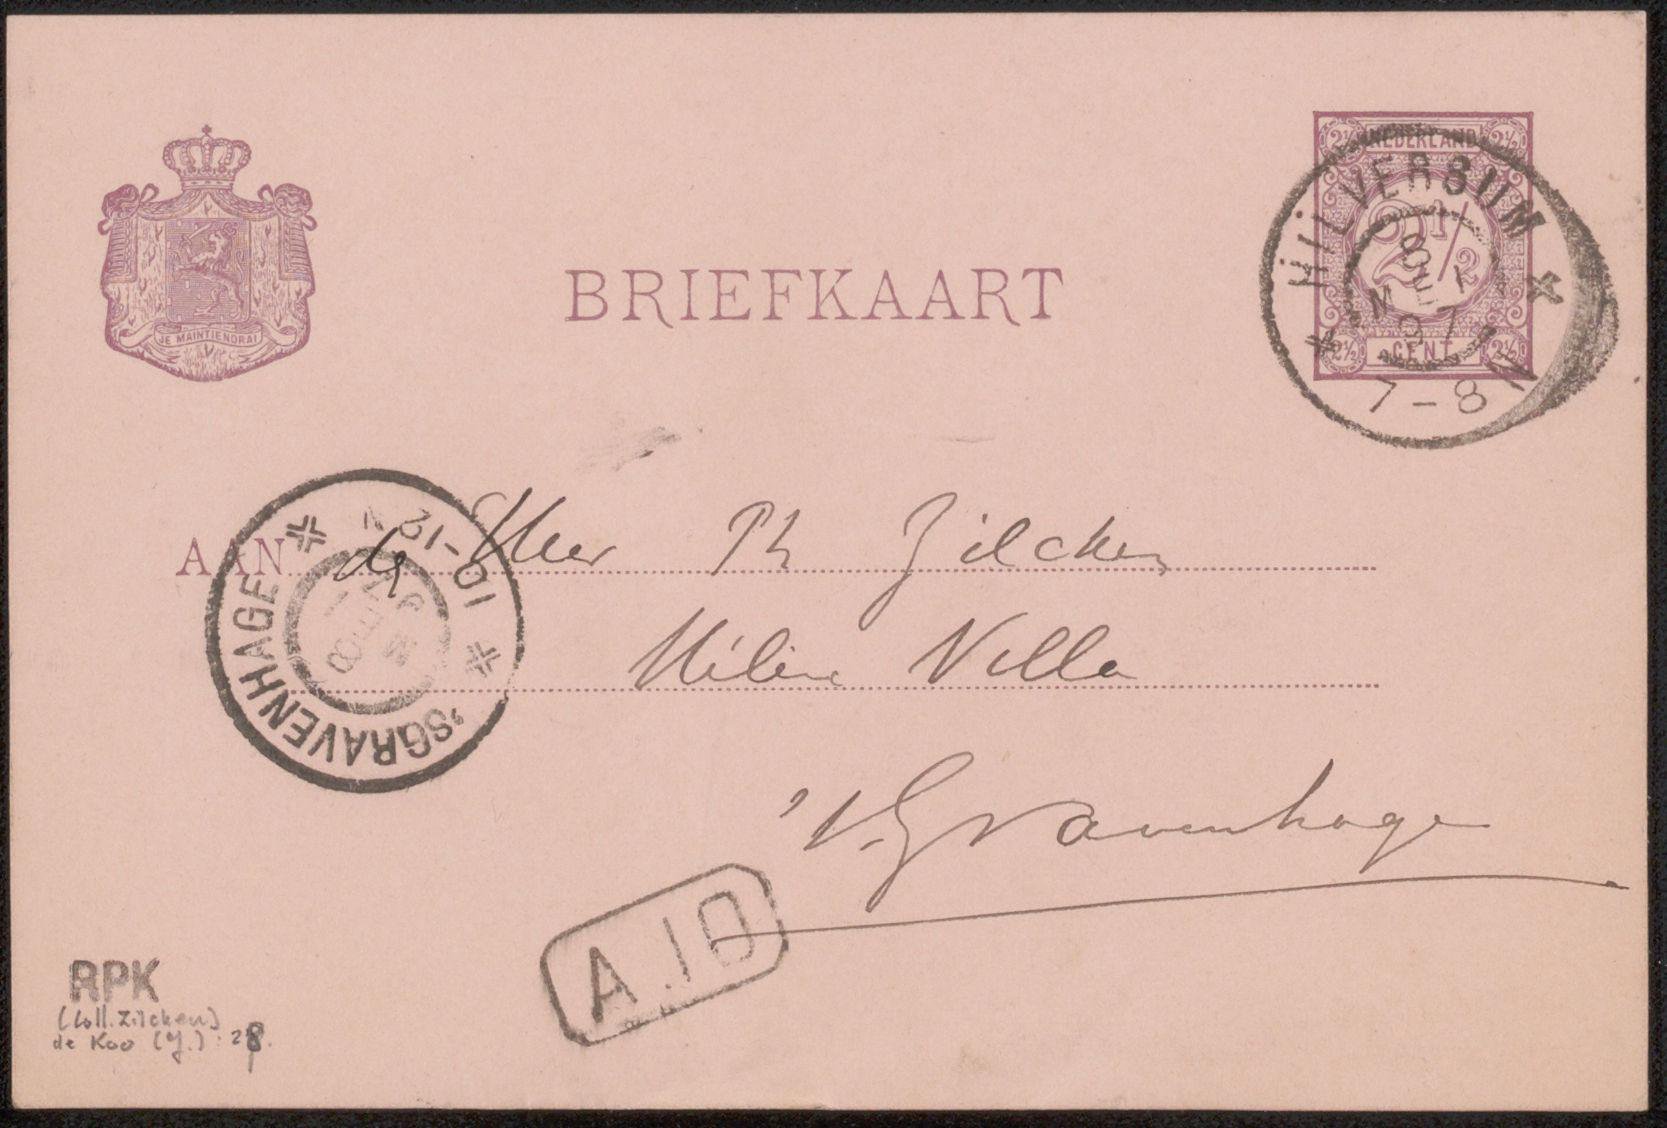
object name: postcard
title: Briefkaart aan Philip Zilcken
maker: johannes de koo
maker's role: auteur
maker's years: 1841-1909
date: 1897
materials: cardboard, ink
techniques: pen, writing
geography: hilversum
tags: the hague, painter, draughtsman, philip zilcken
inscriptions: collector's mark: ‘RPK’